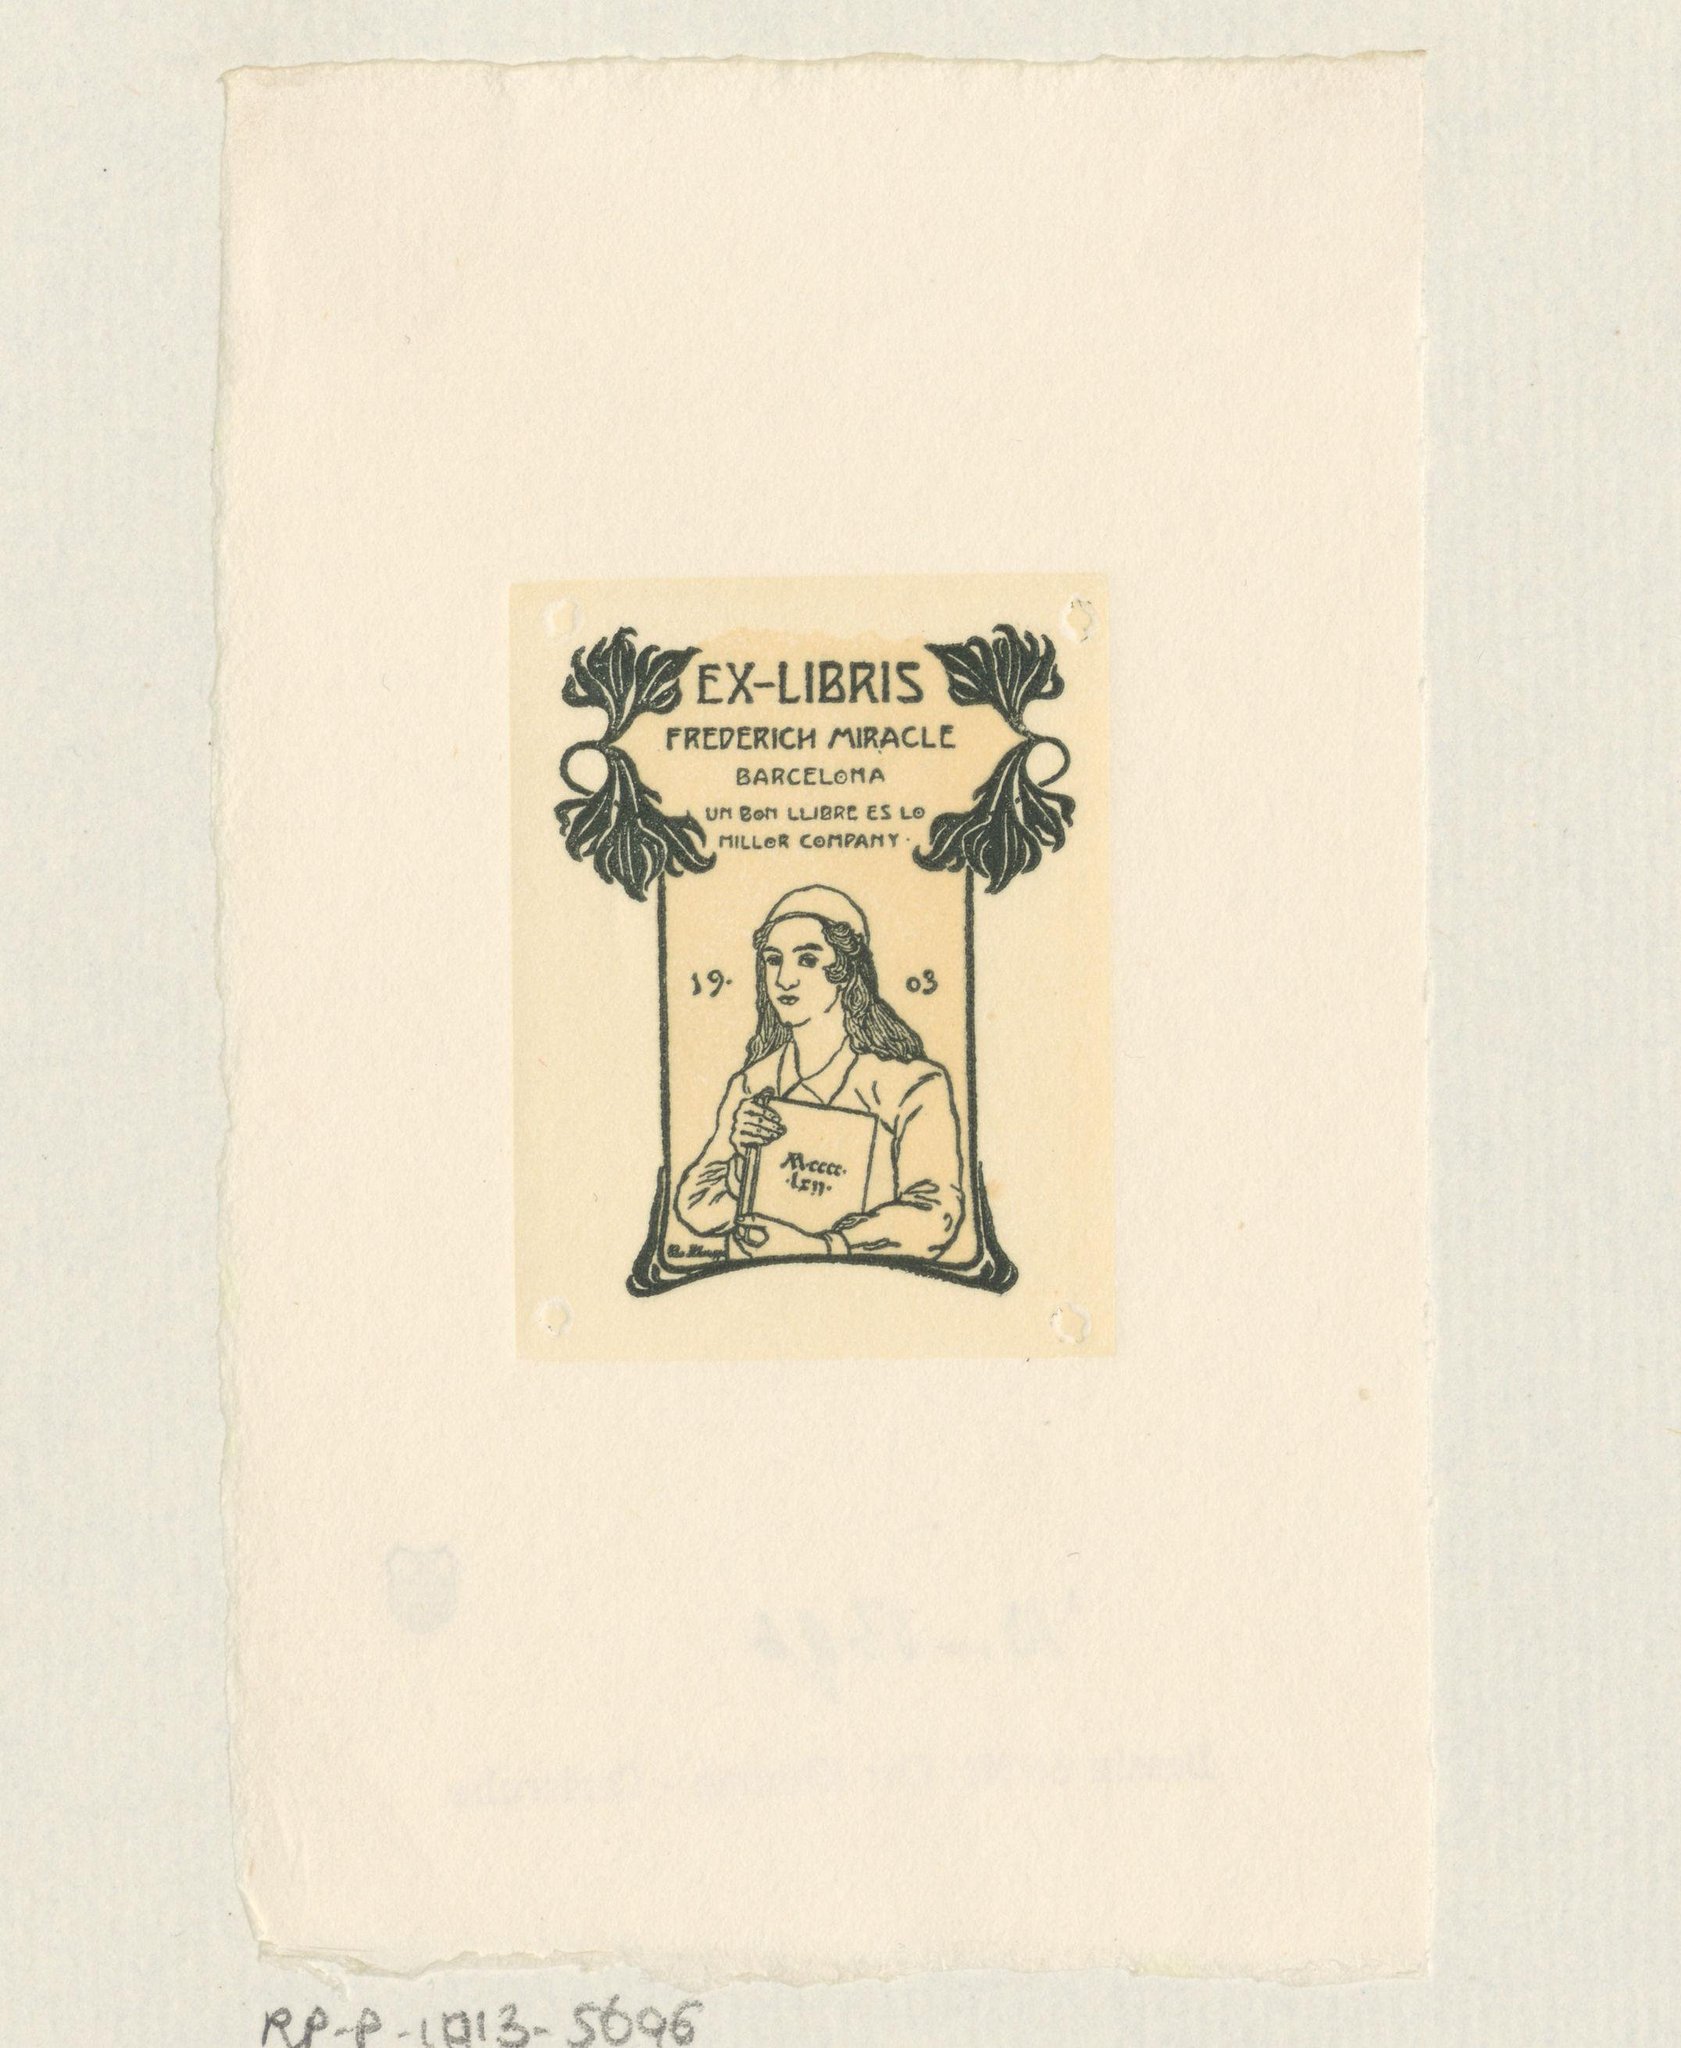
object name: photomechanical print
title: Ex libris van Frederich Miracle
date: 1903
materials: paper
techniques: planographic printing, printing block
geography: karlsruhe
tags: chest, bust, book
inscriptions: collector's mark: Lugt 2760, workshop stamp: ‘Dessin de Mr. Chr. Klumpp - Carlsruhe.’, collector's mark: Lugt 2233